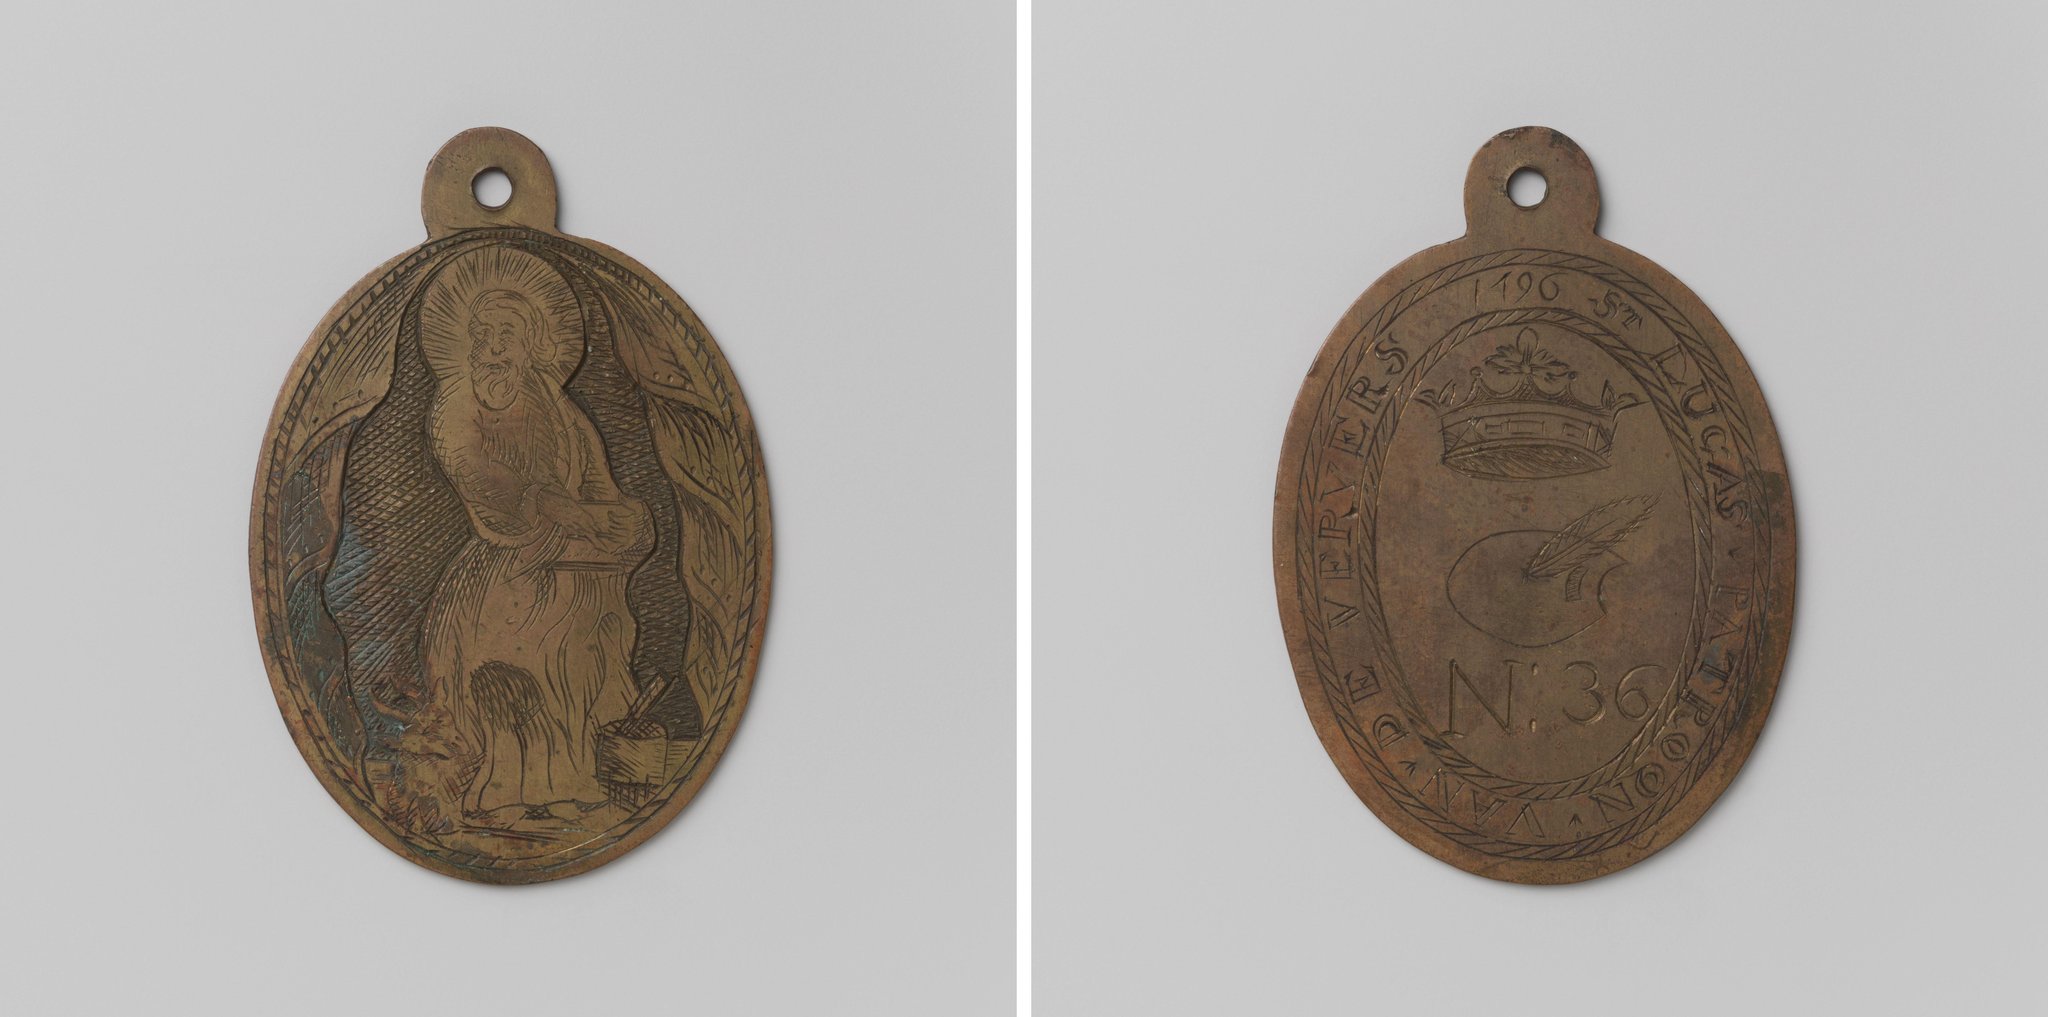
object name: medal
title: Ververs- of St. Lucasgilde van 's-Hertogenbosch, gildepenning met no. 36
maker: Anonymous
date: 1796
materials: brass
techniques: engraving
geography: den bosch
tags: den bosch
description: Messing ovale penning aan draagoog. Voorzijde: staande St. Lucas met aureool, schrijvend in boek; aan zijn voeten liggende os en ververskuip, waar kwast in staat. Keerzijde: gekroond palet boven cijfer 36 binnen omschrift